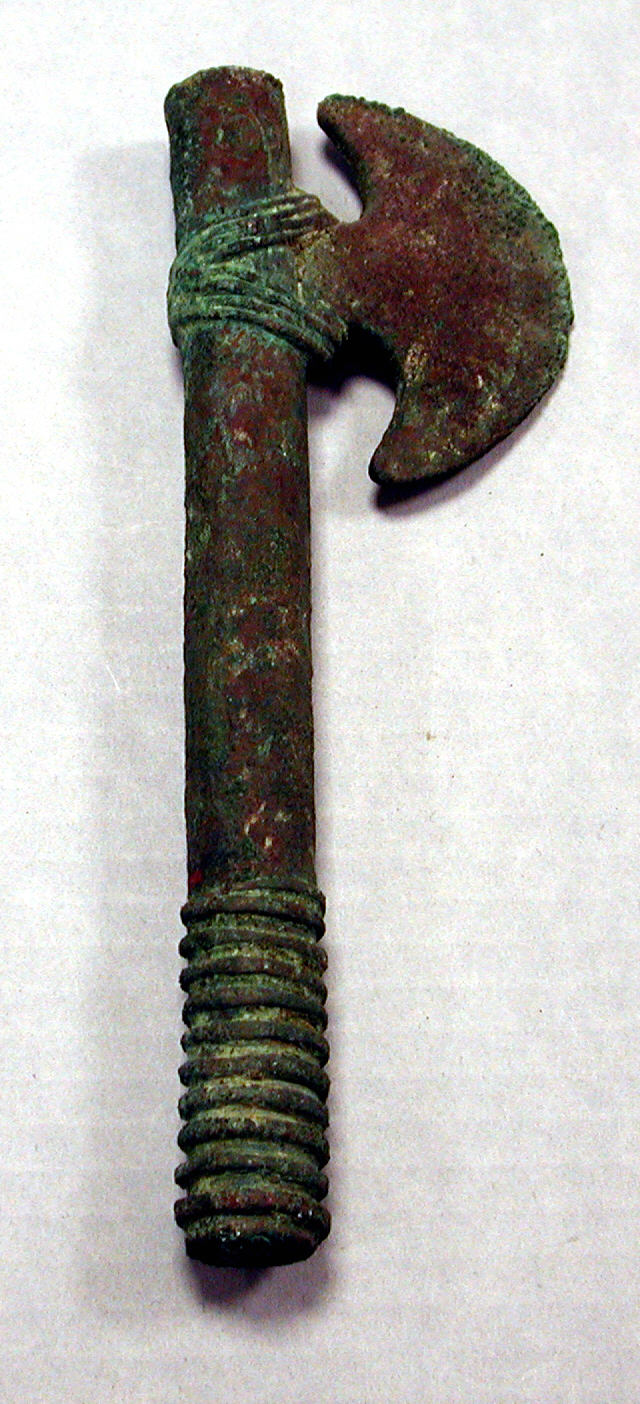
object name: axe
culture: inca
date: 1401-1600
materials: bronze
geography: peru